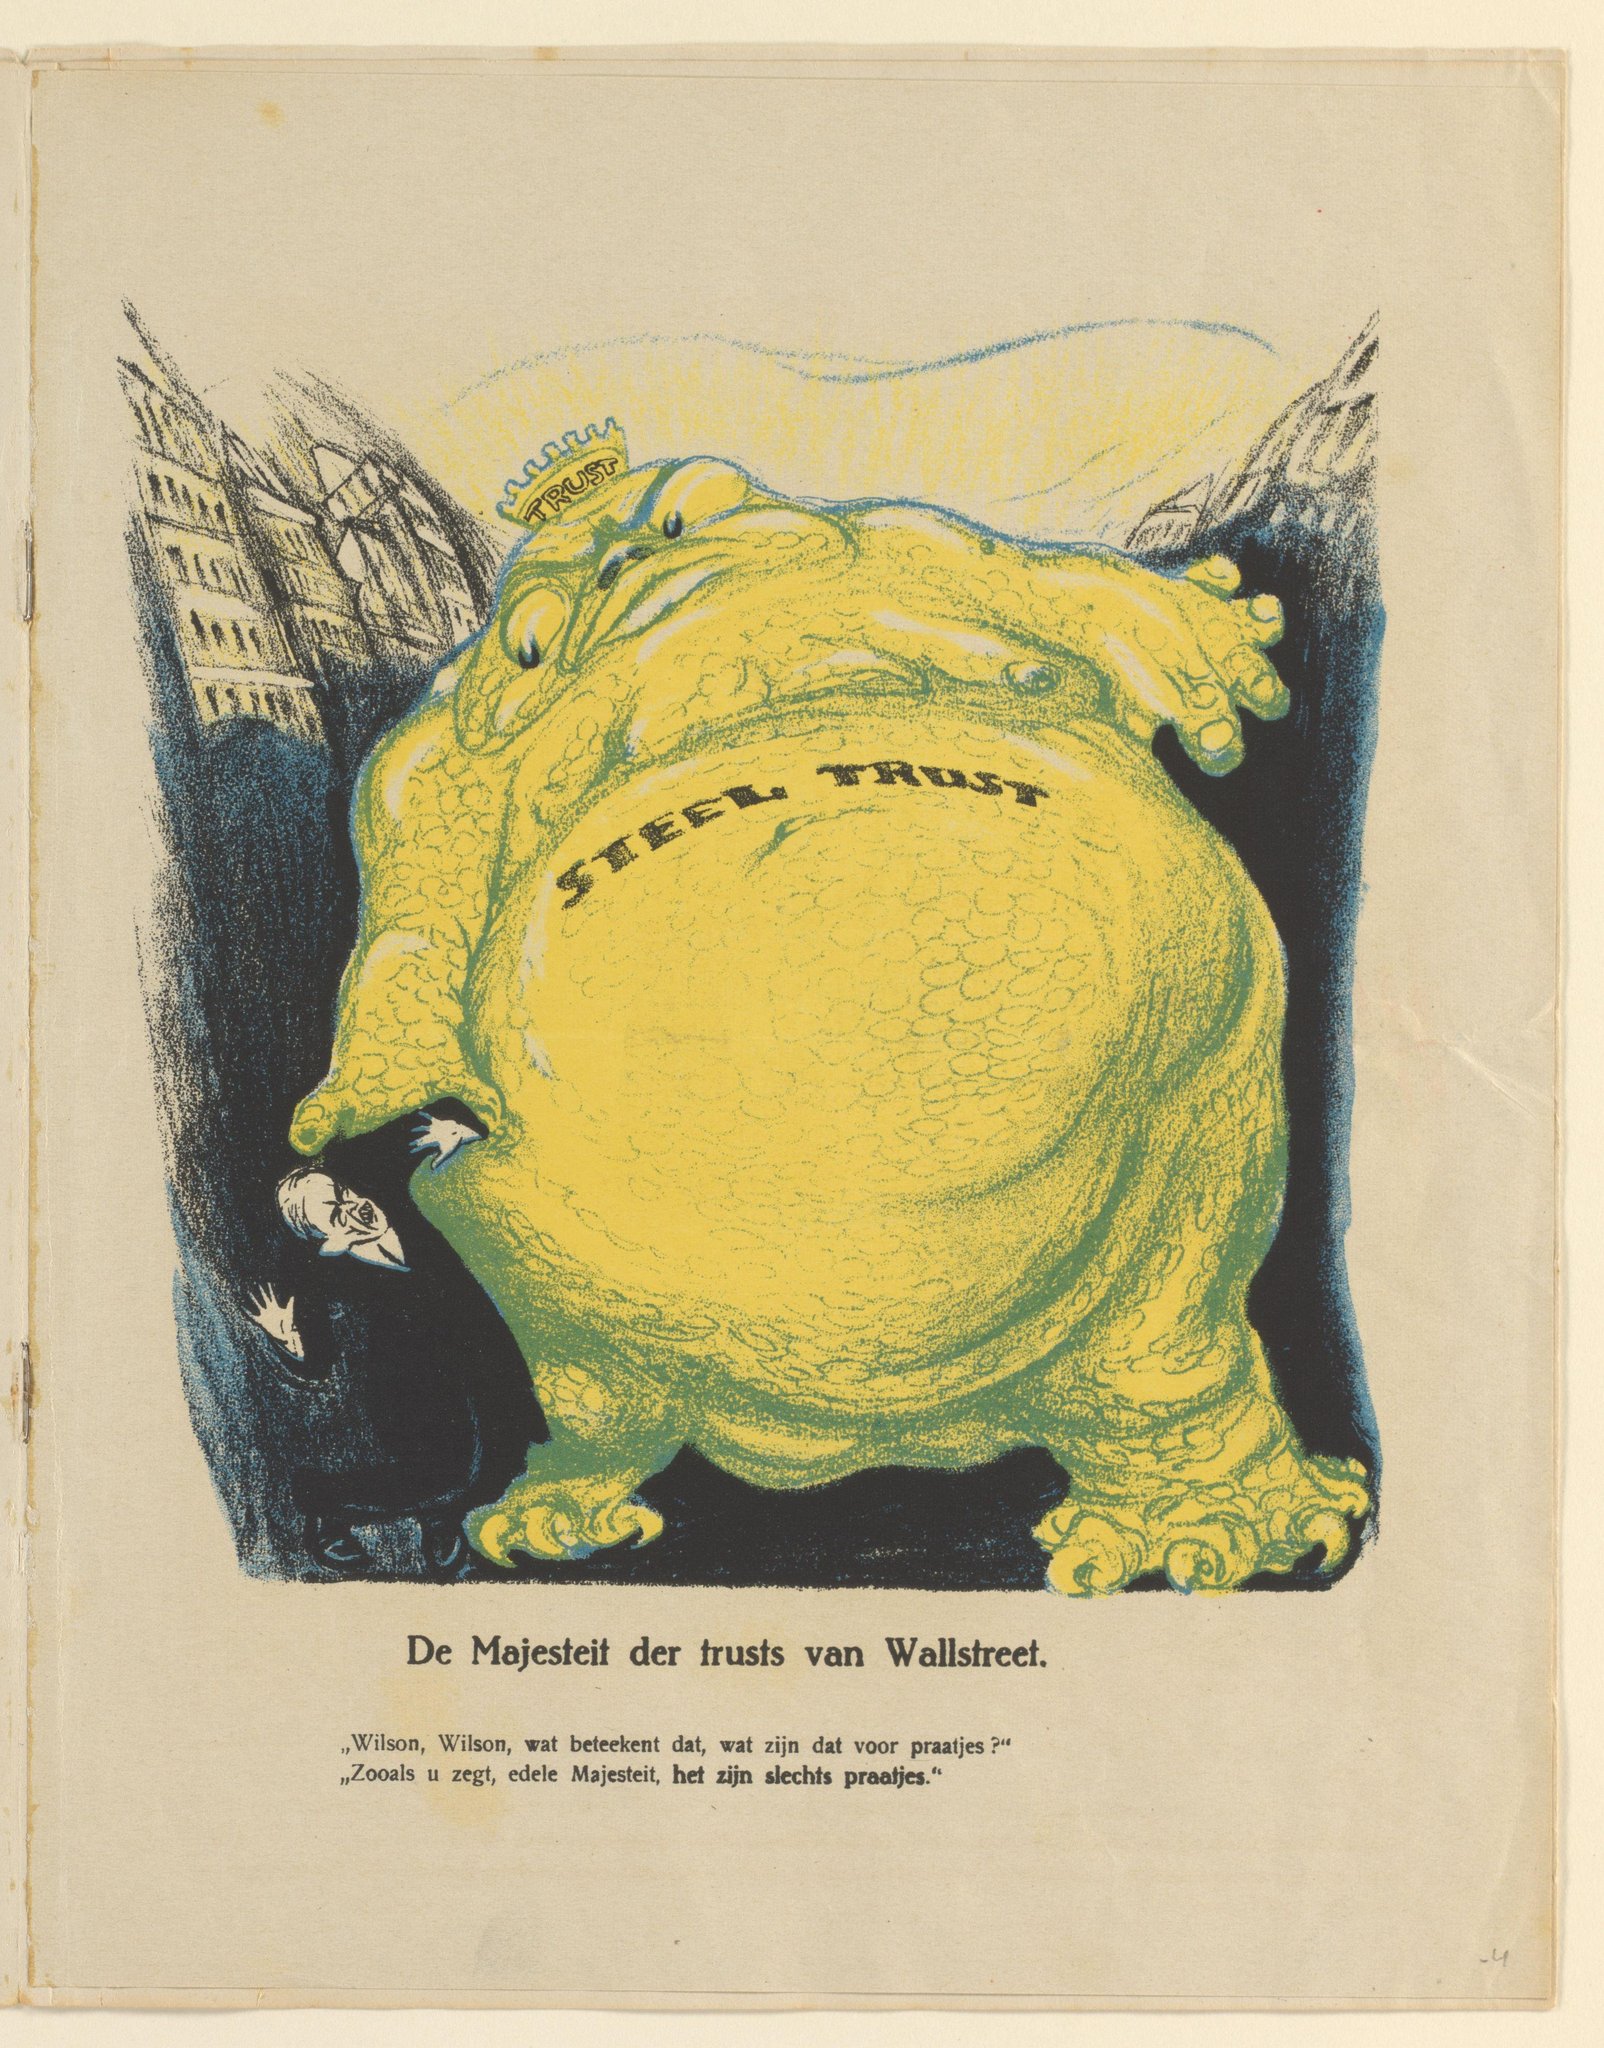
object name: print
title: De majesteit der trusts van Wallstreet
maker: Anonymous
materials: paper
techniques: lithograph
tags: war and peace, political caricatures and satires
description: Prent uit: Bluff. Woorden en daden van Woodrow Wilson president der Vereenigde Staten van Amerika. S.l., s.n., [ca. 1917].